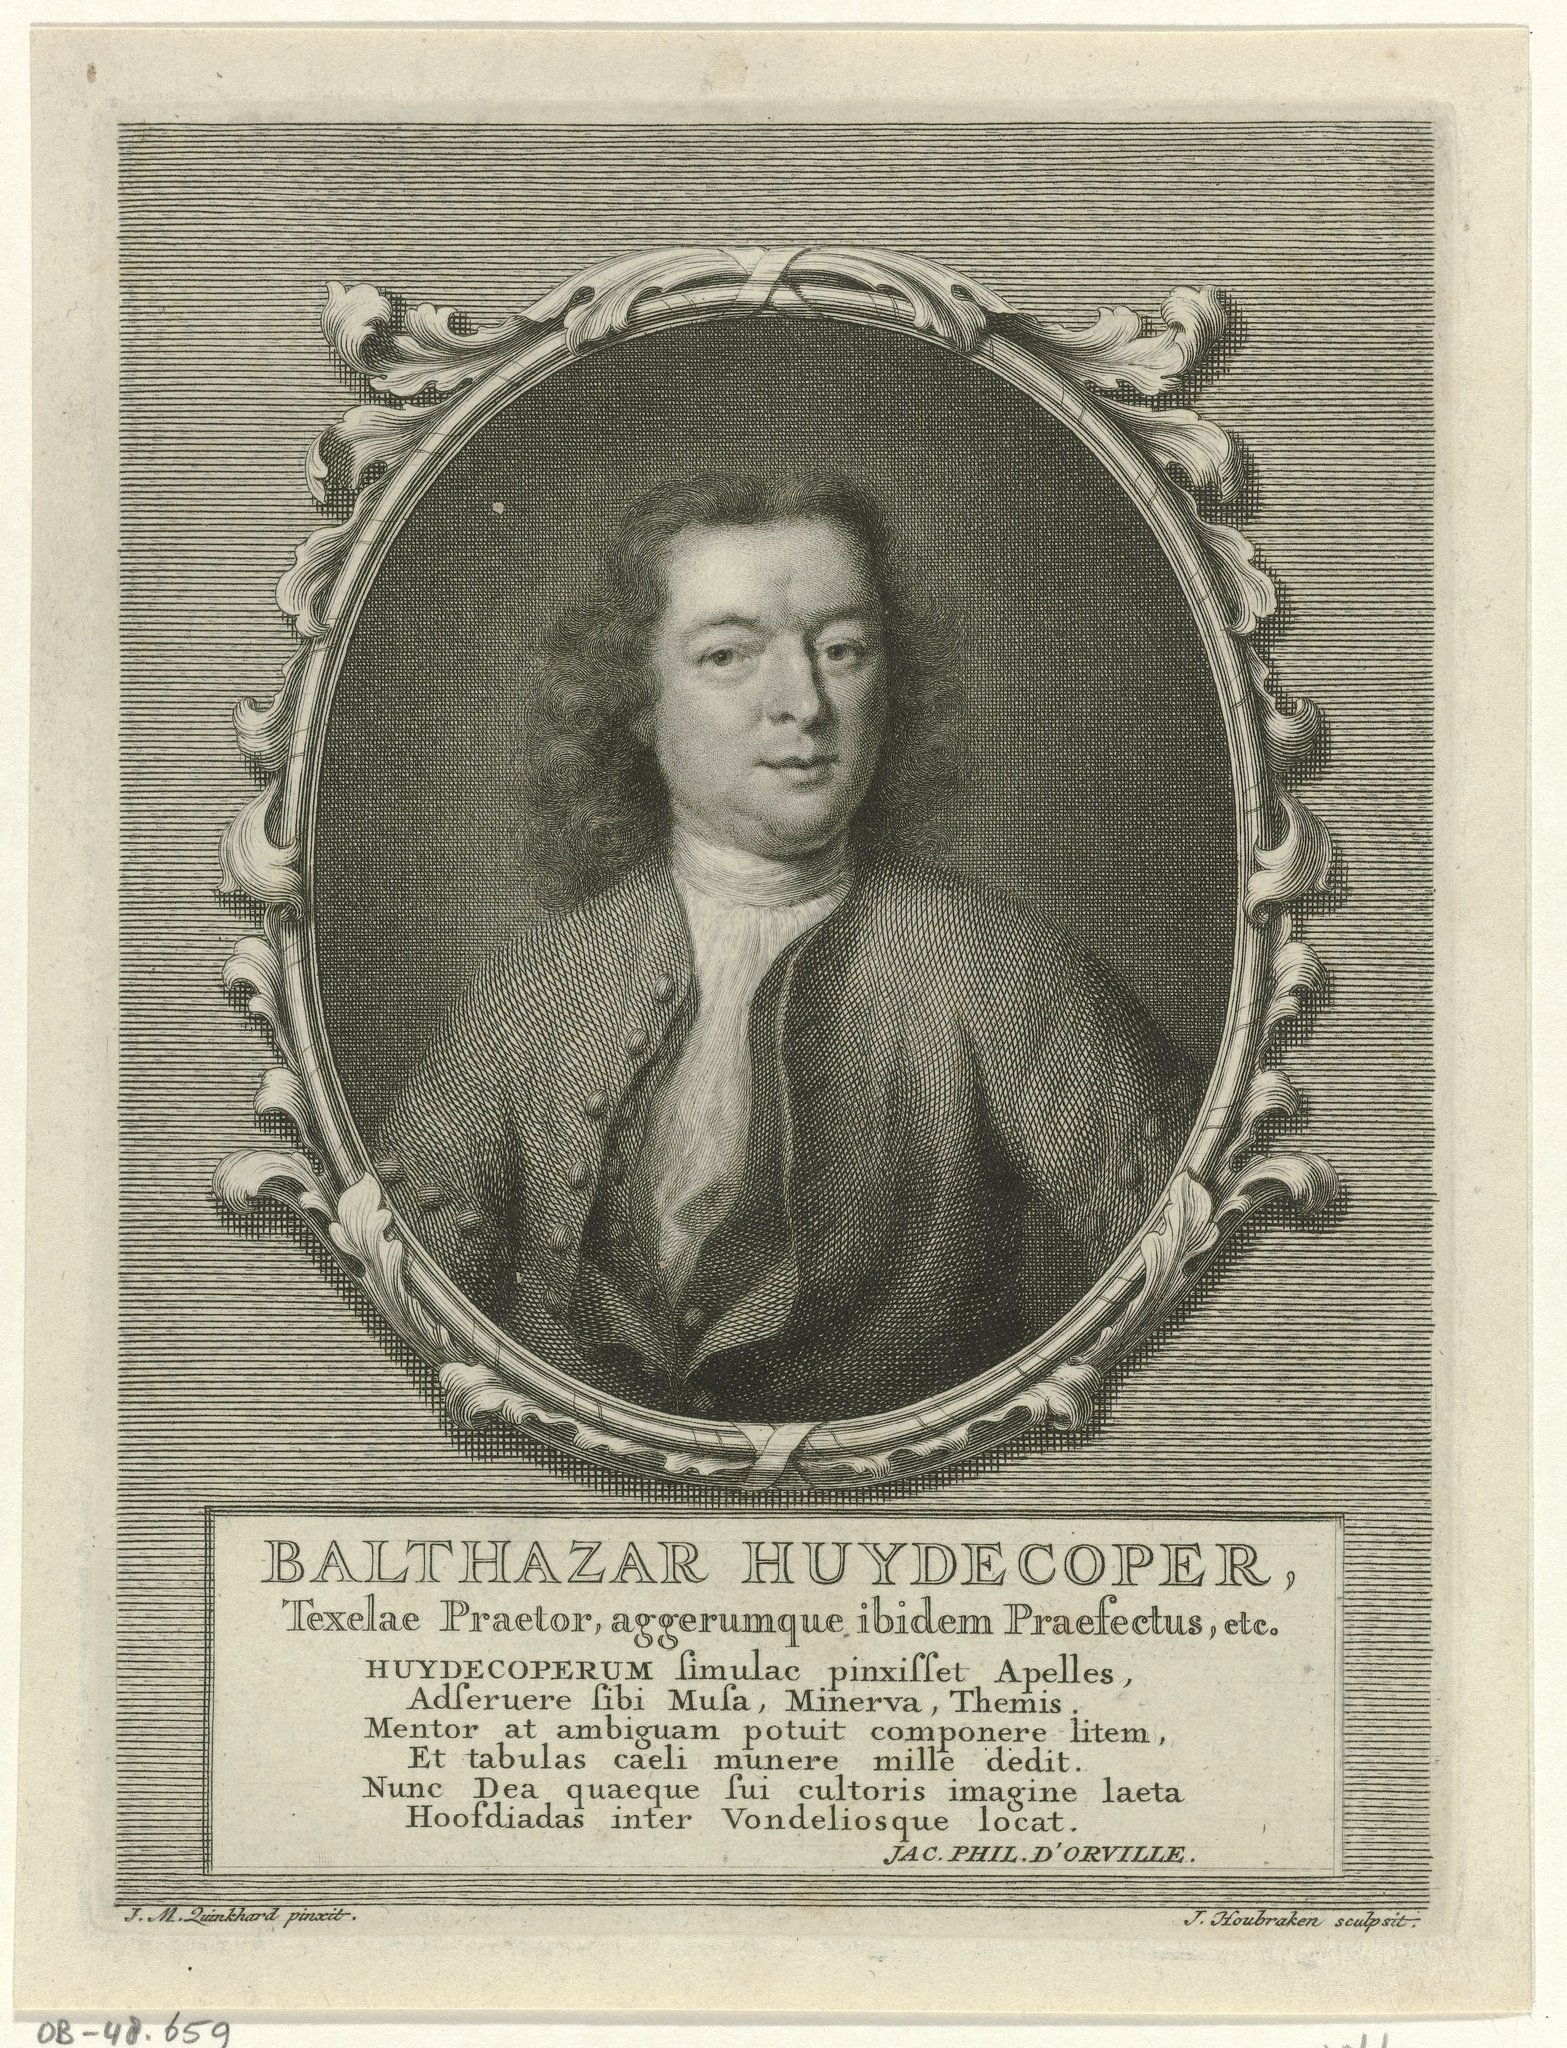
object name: print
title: Portret van Balthazar Huydecoper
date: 1737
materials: paper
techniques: engraving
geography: amsterdam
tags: balthazar huydecoper, historical persons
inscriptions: collector's mark: Lugt 2228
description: Portret van Balthazar Huydecoper in een ovaal. Onder het portret een kader met zijn naam en gegevens in twee regels in het Latijn en een tekst in zes regels in het Latijn.